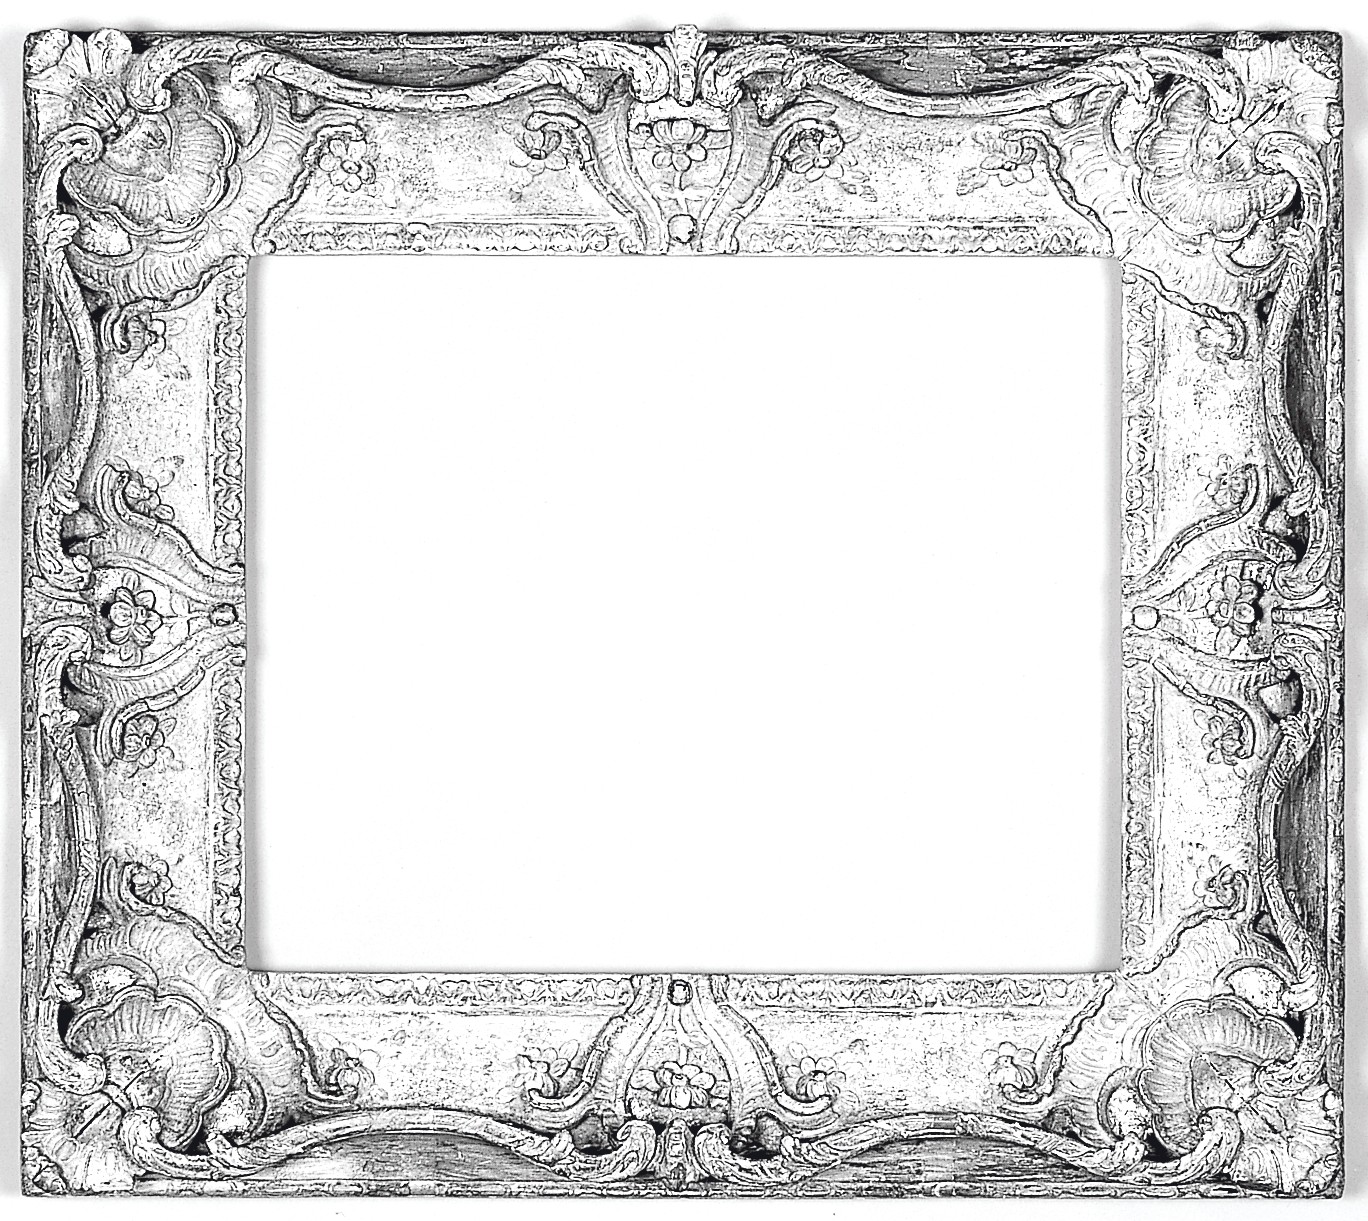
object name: frame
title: Swept frame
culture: french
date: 1750-1760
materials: feather, wood